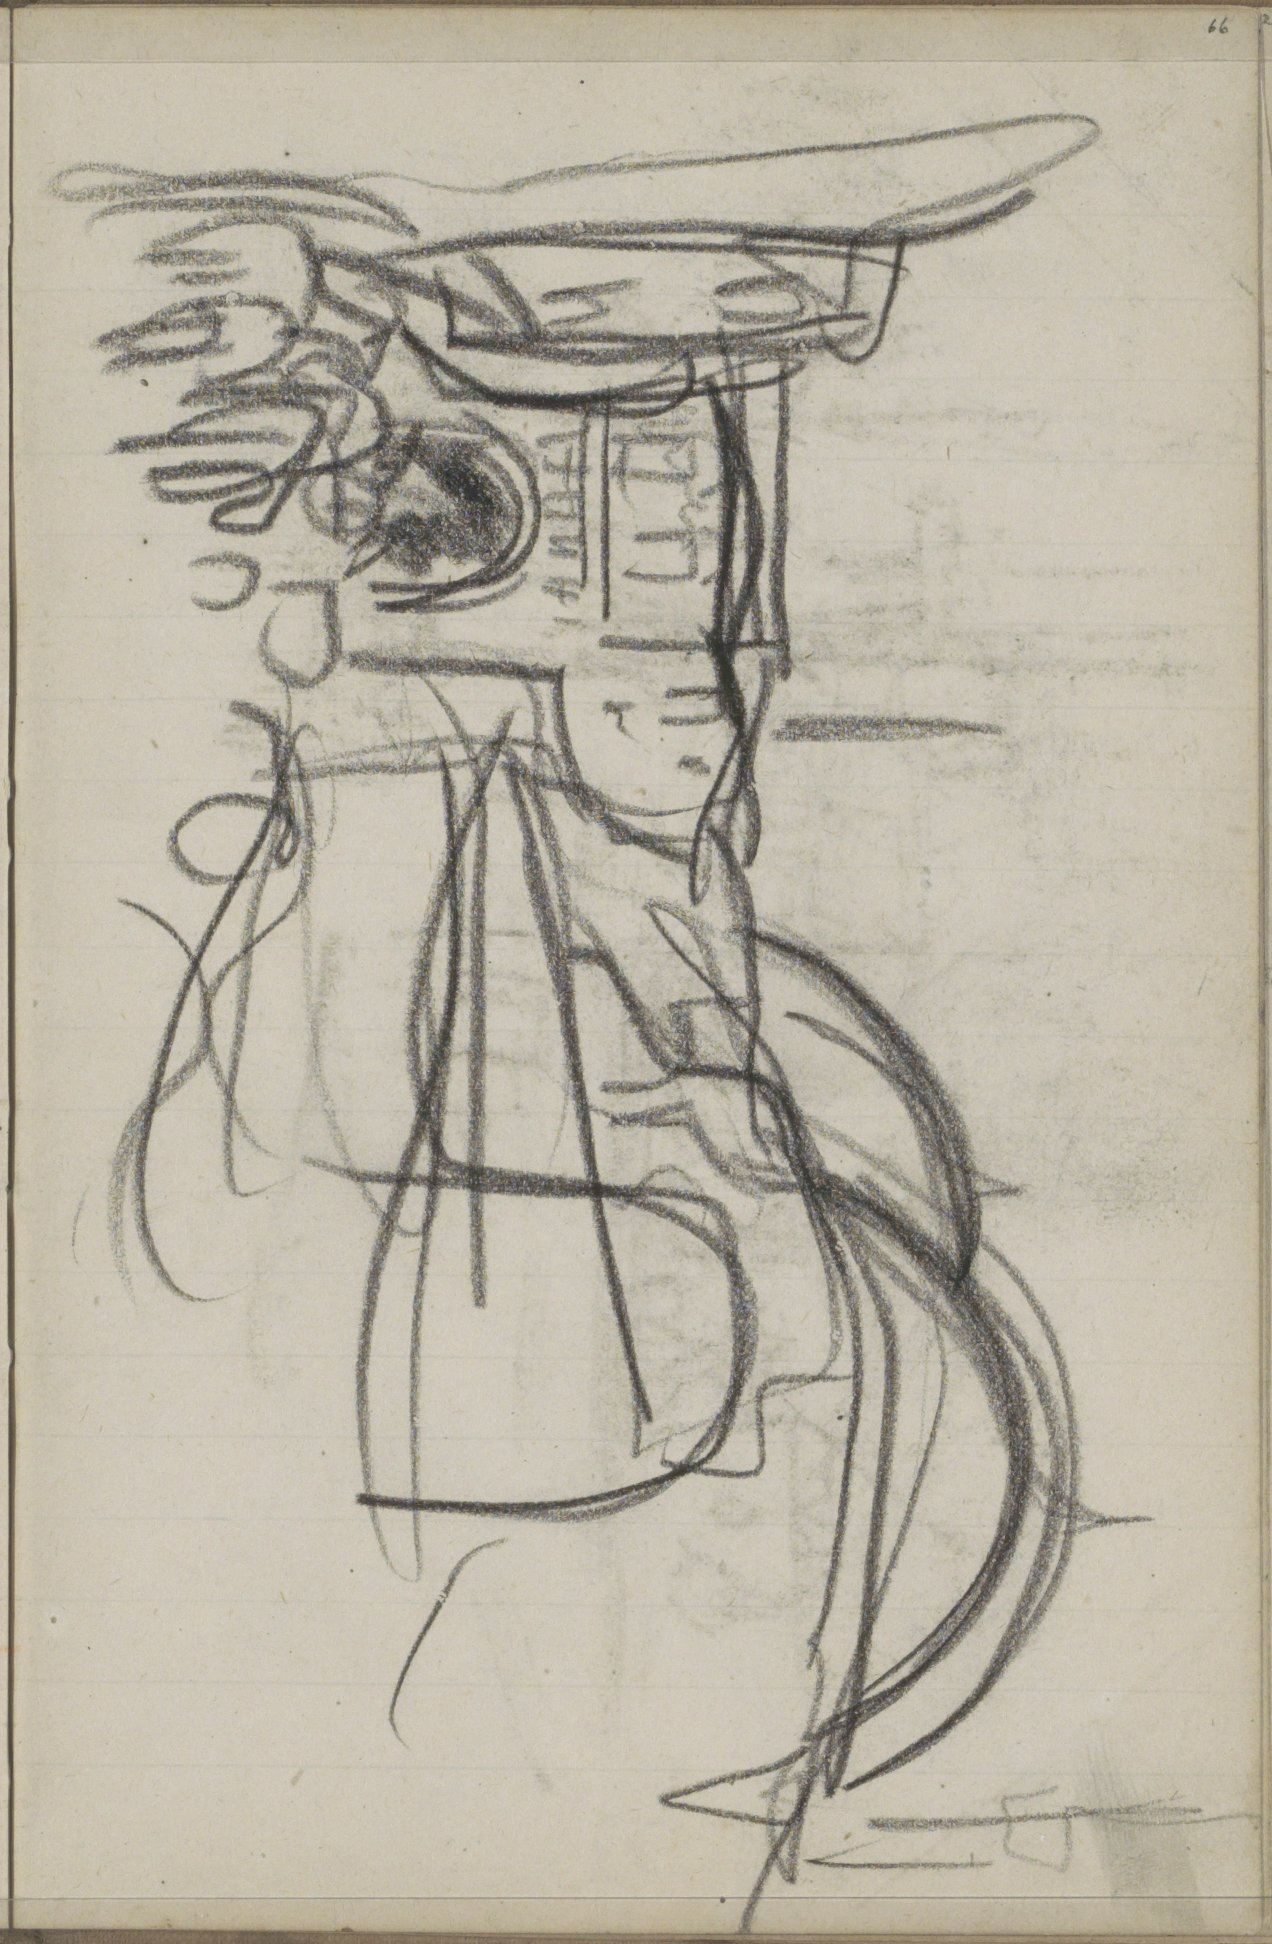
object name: sketchbook leaf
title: Straat met een poort en koepeldaken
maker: marius bauer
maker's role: draughtsman, print maker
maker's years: 1867-1932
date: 1888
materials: chalk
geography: istanbul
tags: arch, archivolt ~ architecture, dome ~ architecture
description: Mogelijk de daken van een moskee. Pagina 66 uit een schetsboek met 56 bladen.